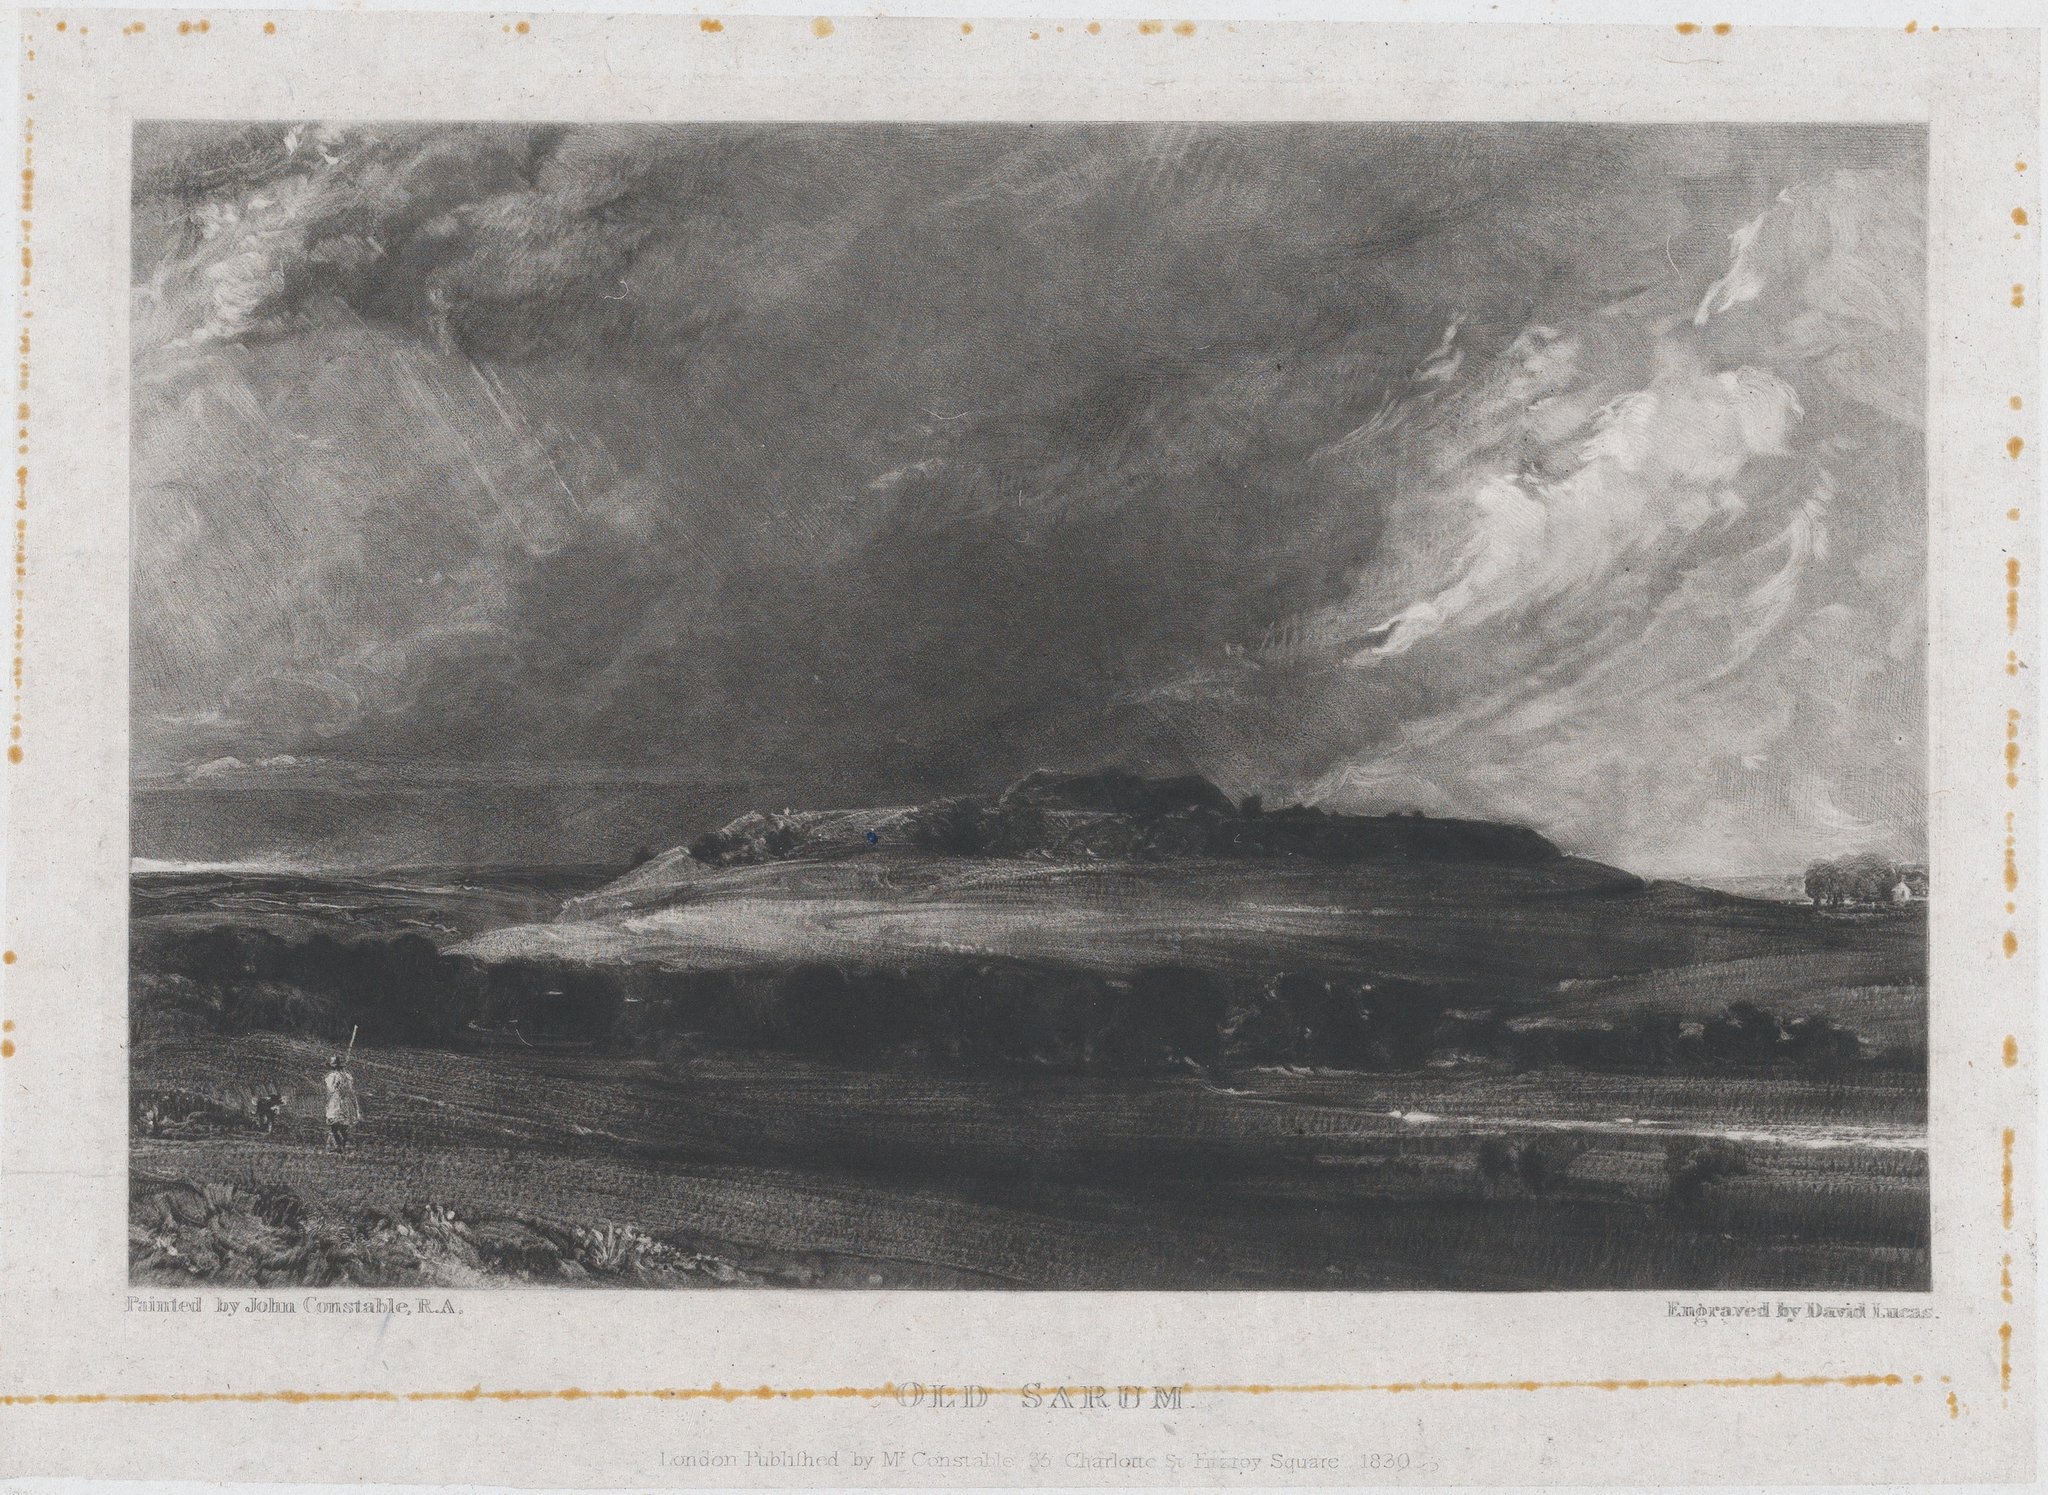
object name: print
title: Old Sarum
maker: david lucas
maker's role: artist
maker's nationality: british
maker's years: 1802-1881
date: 1830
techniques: mezzotint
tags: landscapes,clouds